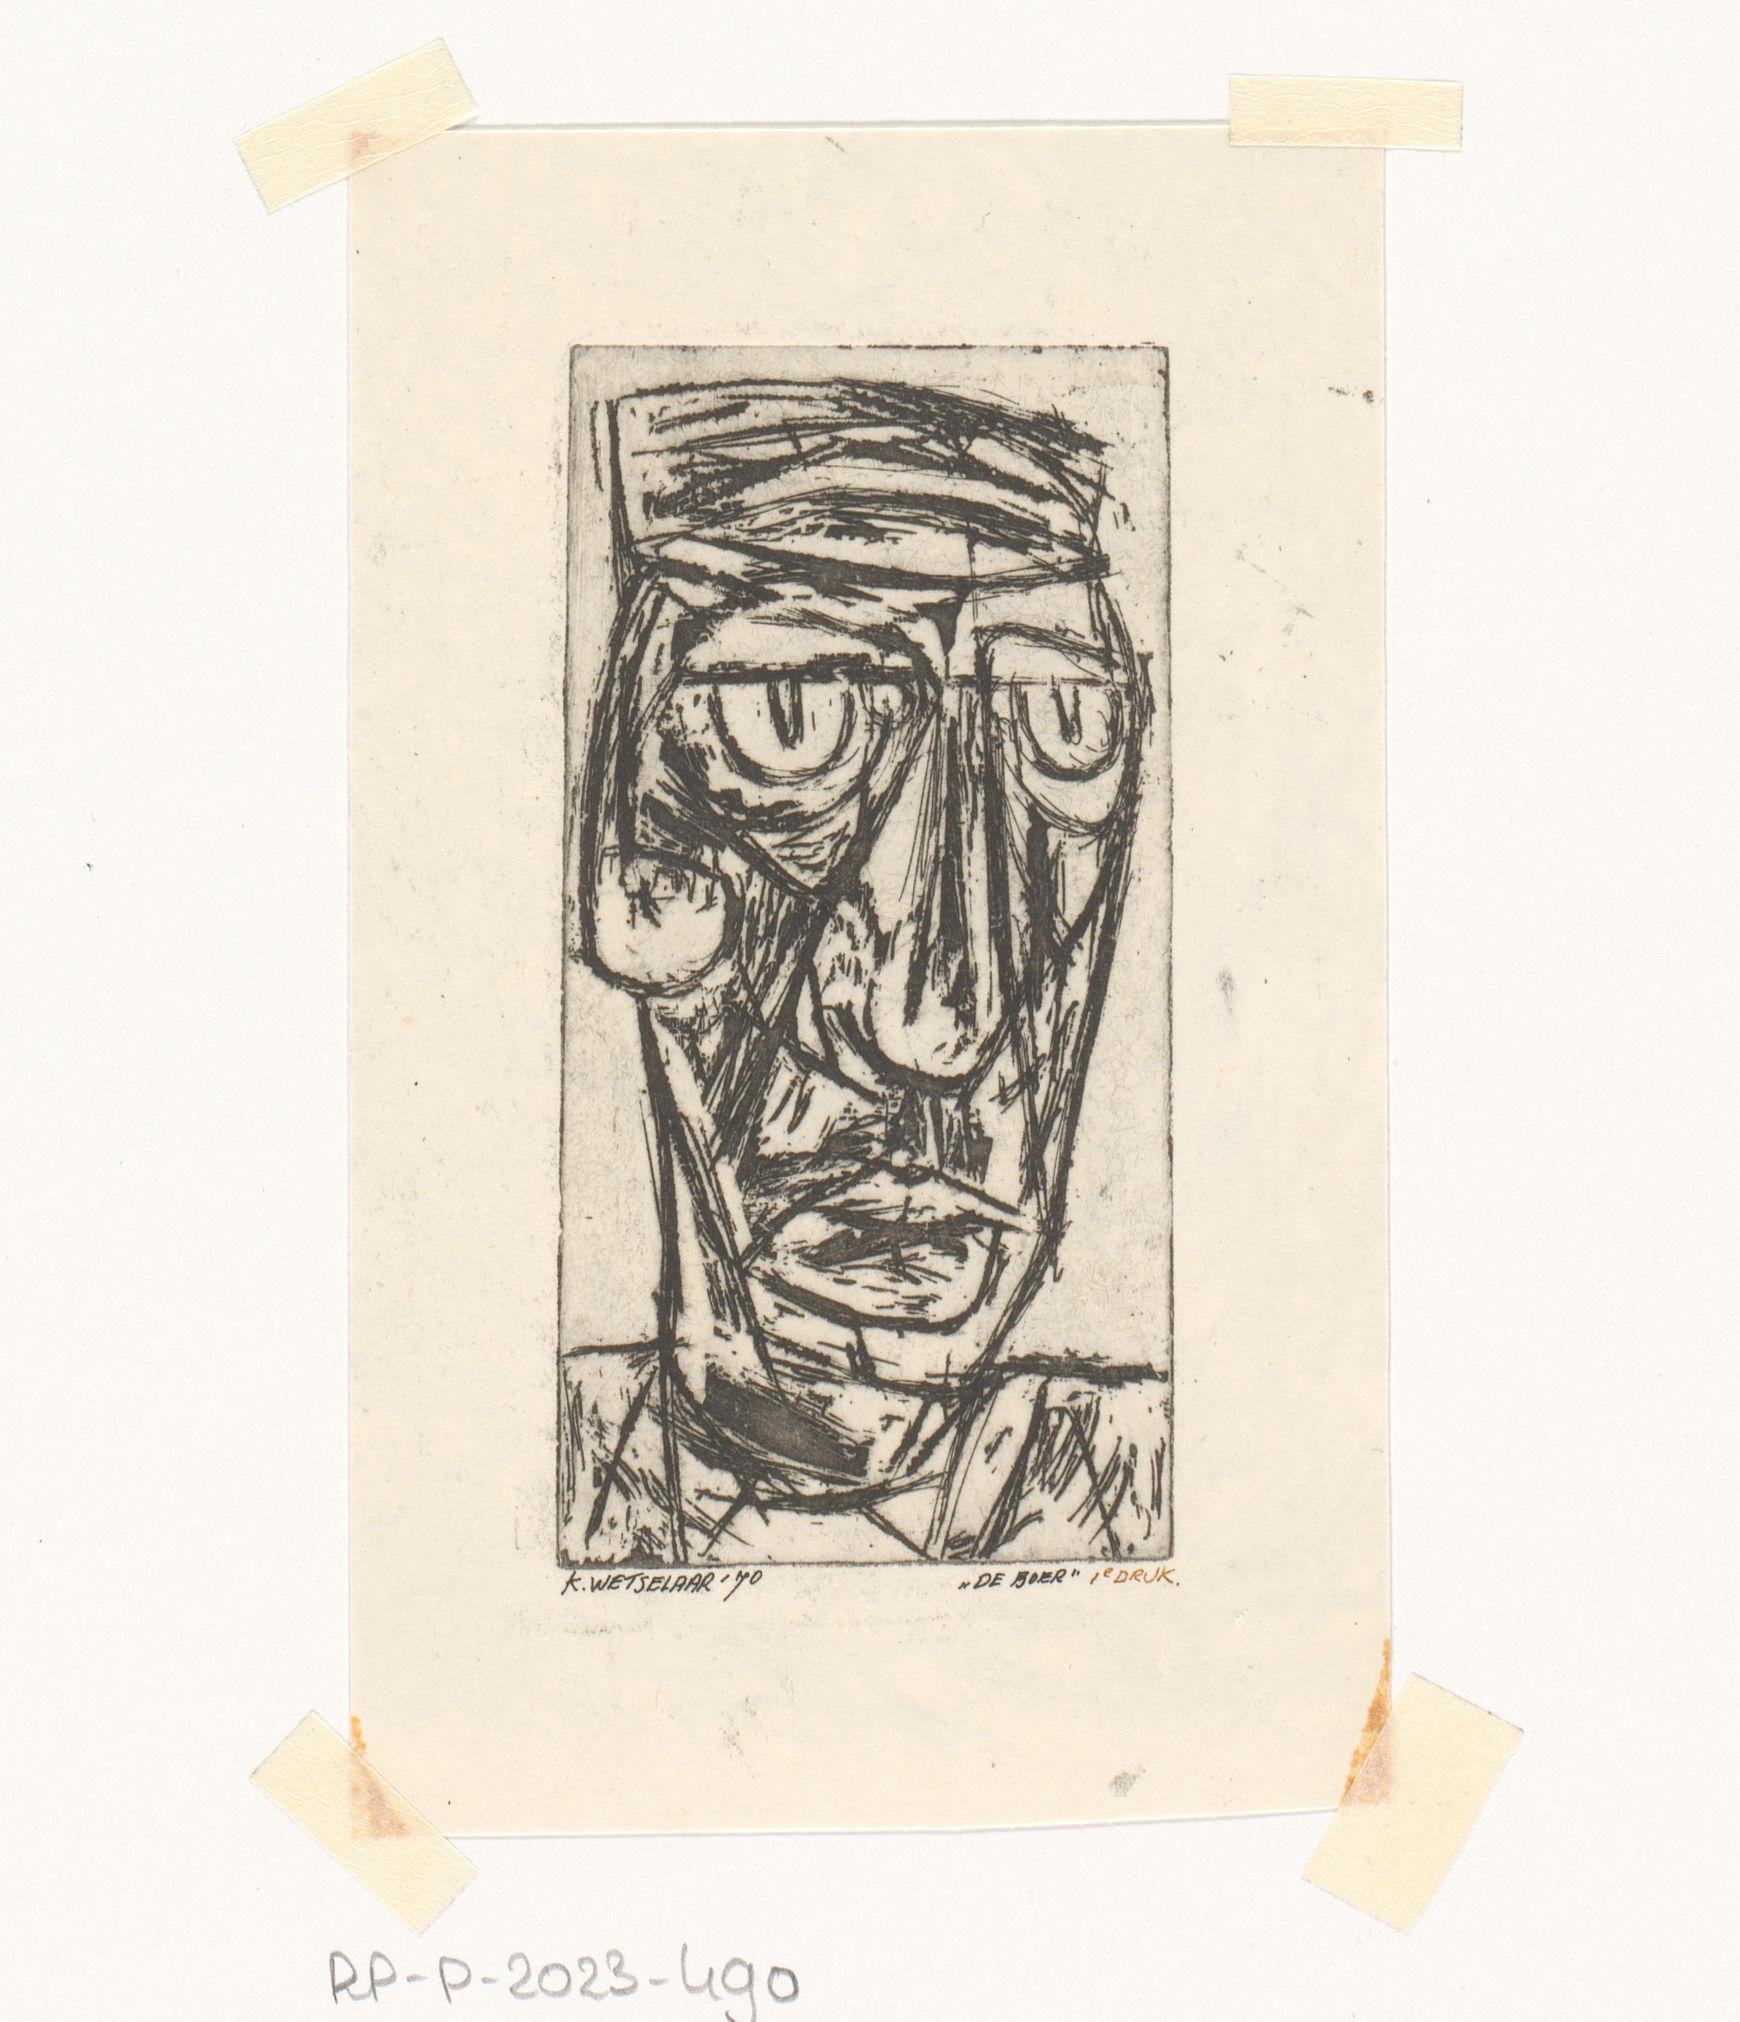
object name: print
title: De Boer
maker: karel wetselaar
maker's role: print maker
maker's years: 1935-2017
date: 1970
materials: paper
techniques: drypoint, etching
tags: farmers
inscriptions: inscription: ‘1e druk.’, signature and date: ‘K. Wetselaar '70’